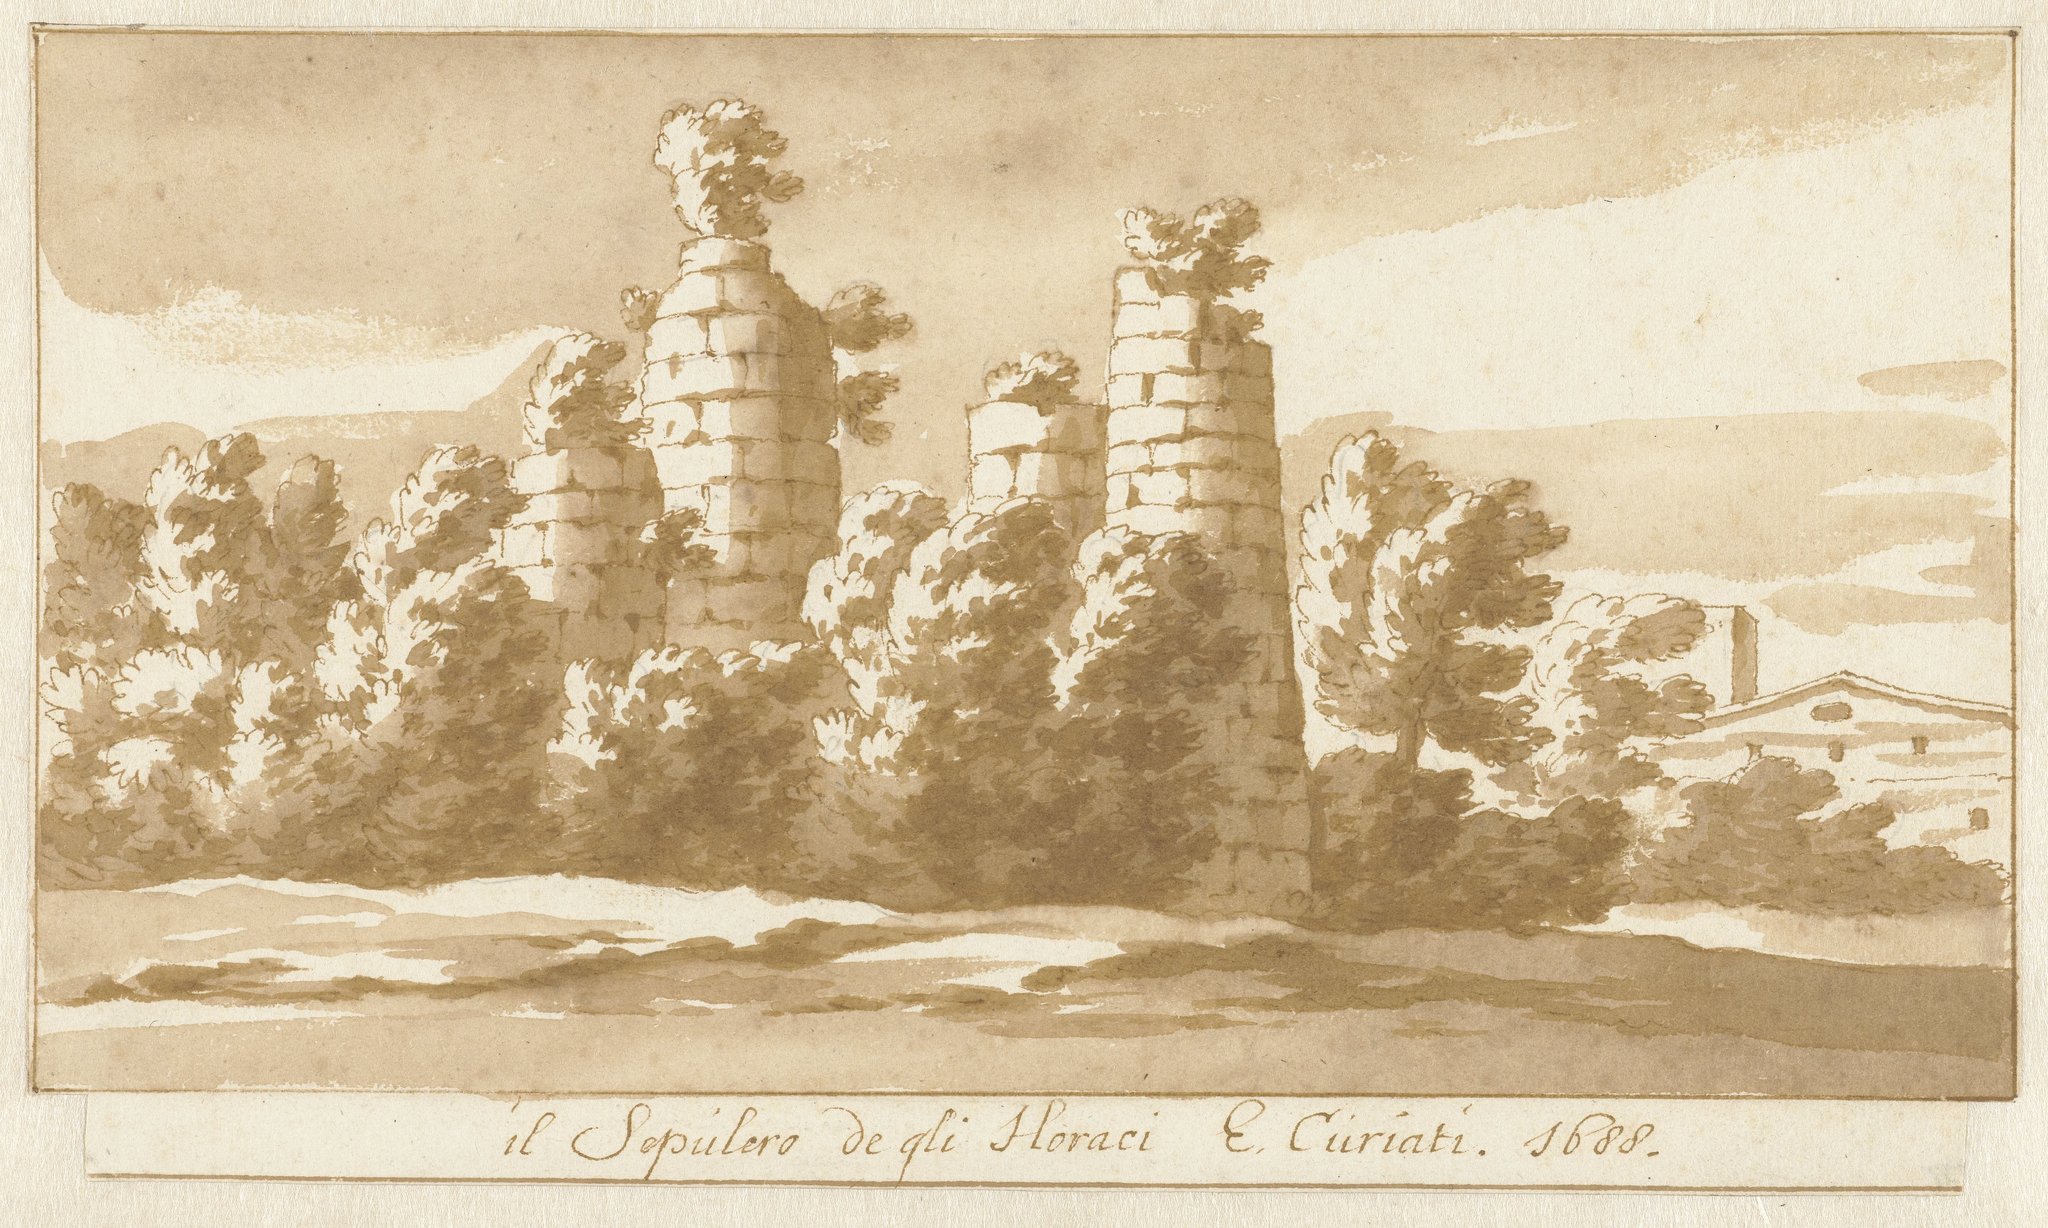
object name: drawing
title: Graf van de Horatii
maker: jacob van der ulft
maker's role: draughtsman, painter, print maker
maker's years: 1627-1689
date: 1688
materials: ink, paper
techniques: brush, pen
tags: grave-building, monumental tomb, rome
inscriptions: : ‘Il Sepulcro de gli Horaci E Curiati’